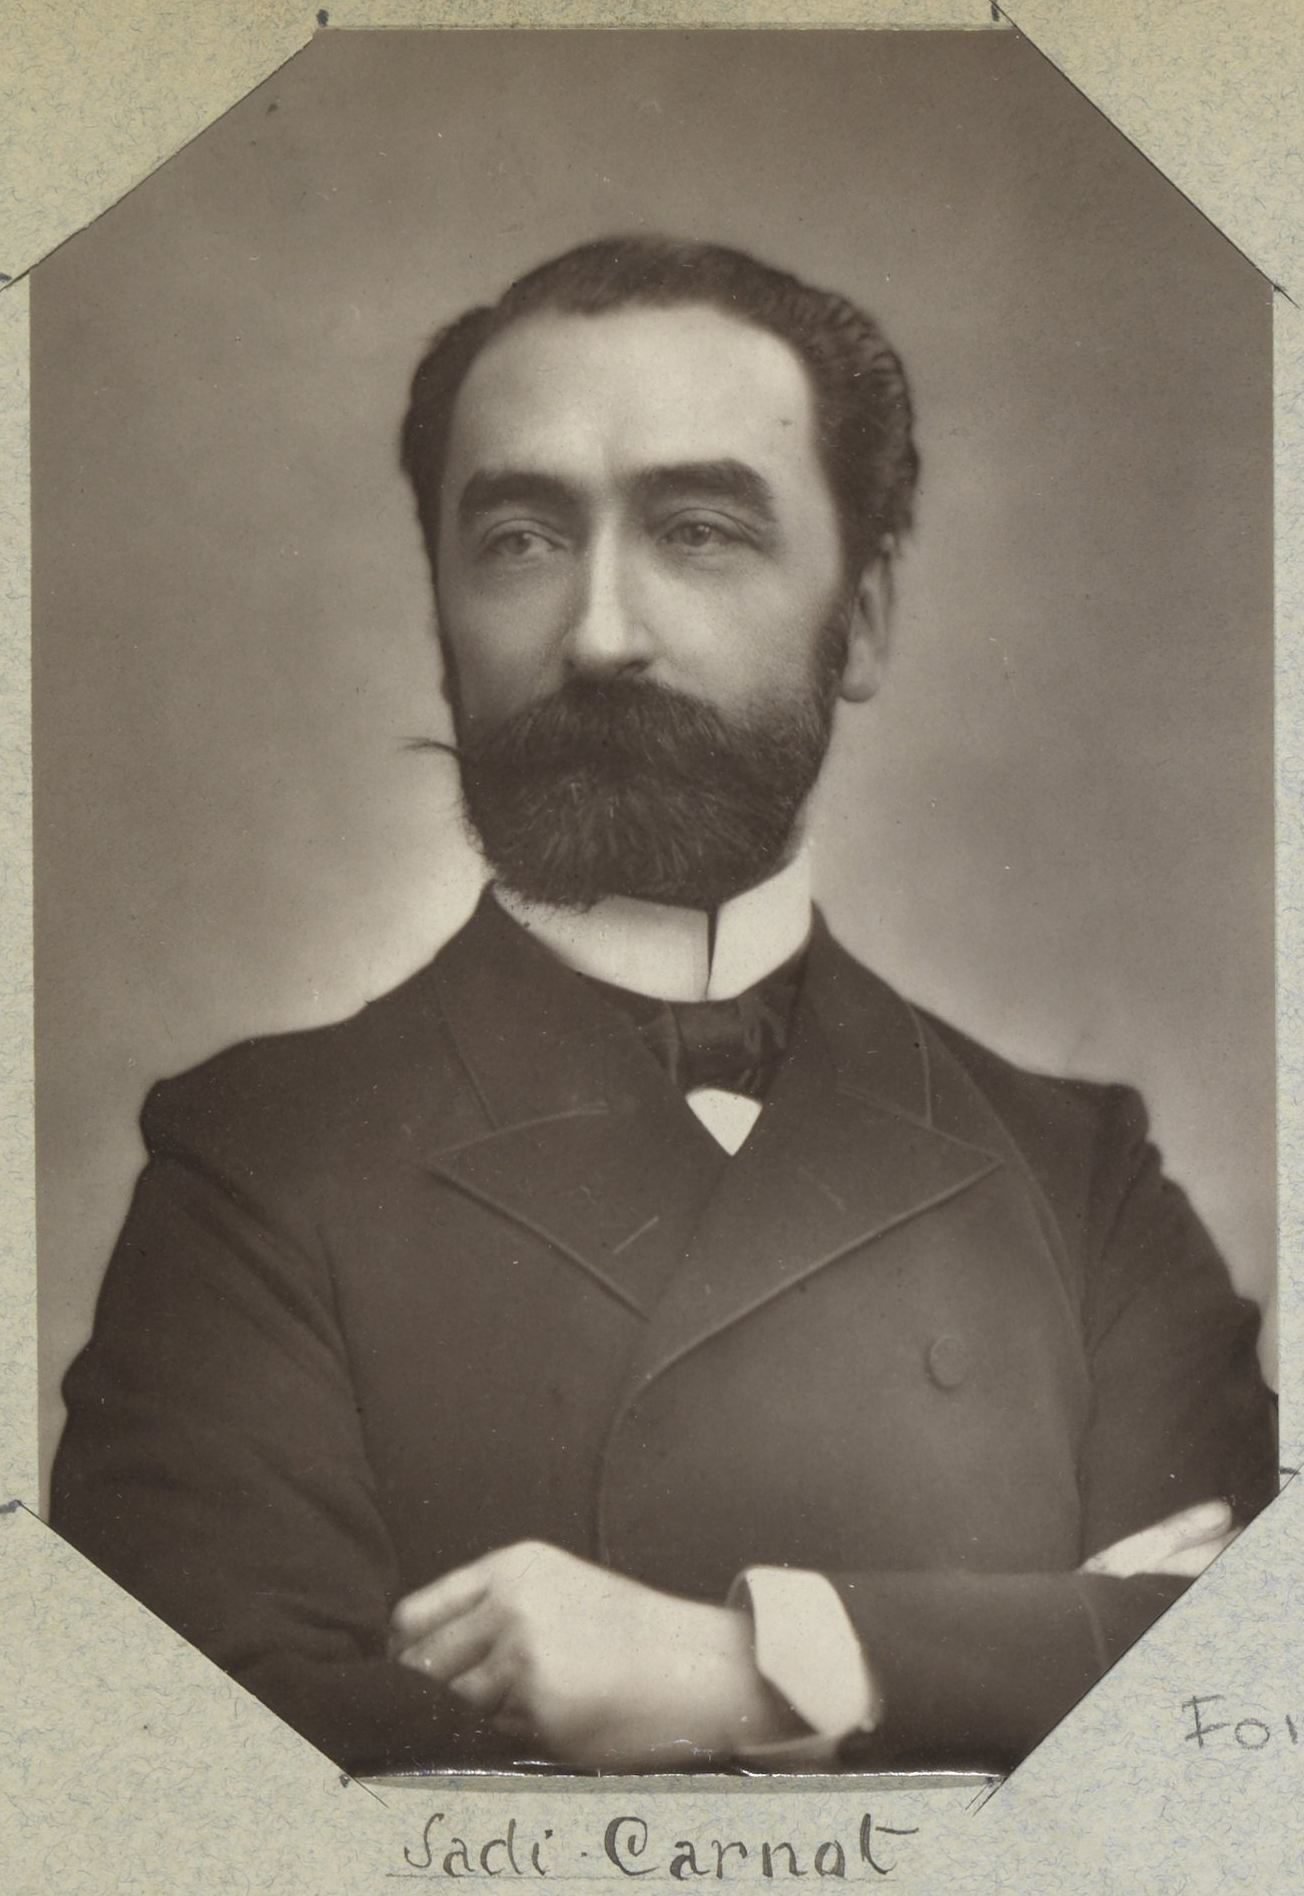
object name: album leaf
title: Portret van Marie François Sadi Carnot, Frans staatsman en president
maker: Anonymous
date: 1880-1894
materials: paper, photographic support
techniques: carbon print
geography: paris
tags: president ~ head of republic, politician, e.g. party leader, france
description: Onderdeel van Album van een Franse amateur met foto's van Frankrijk, Algerije, Palmyra, de Wereldtentoonstelling van 1900 en van bekende Fransen.